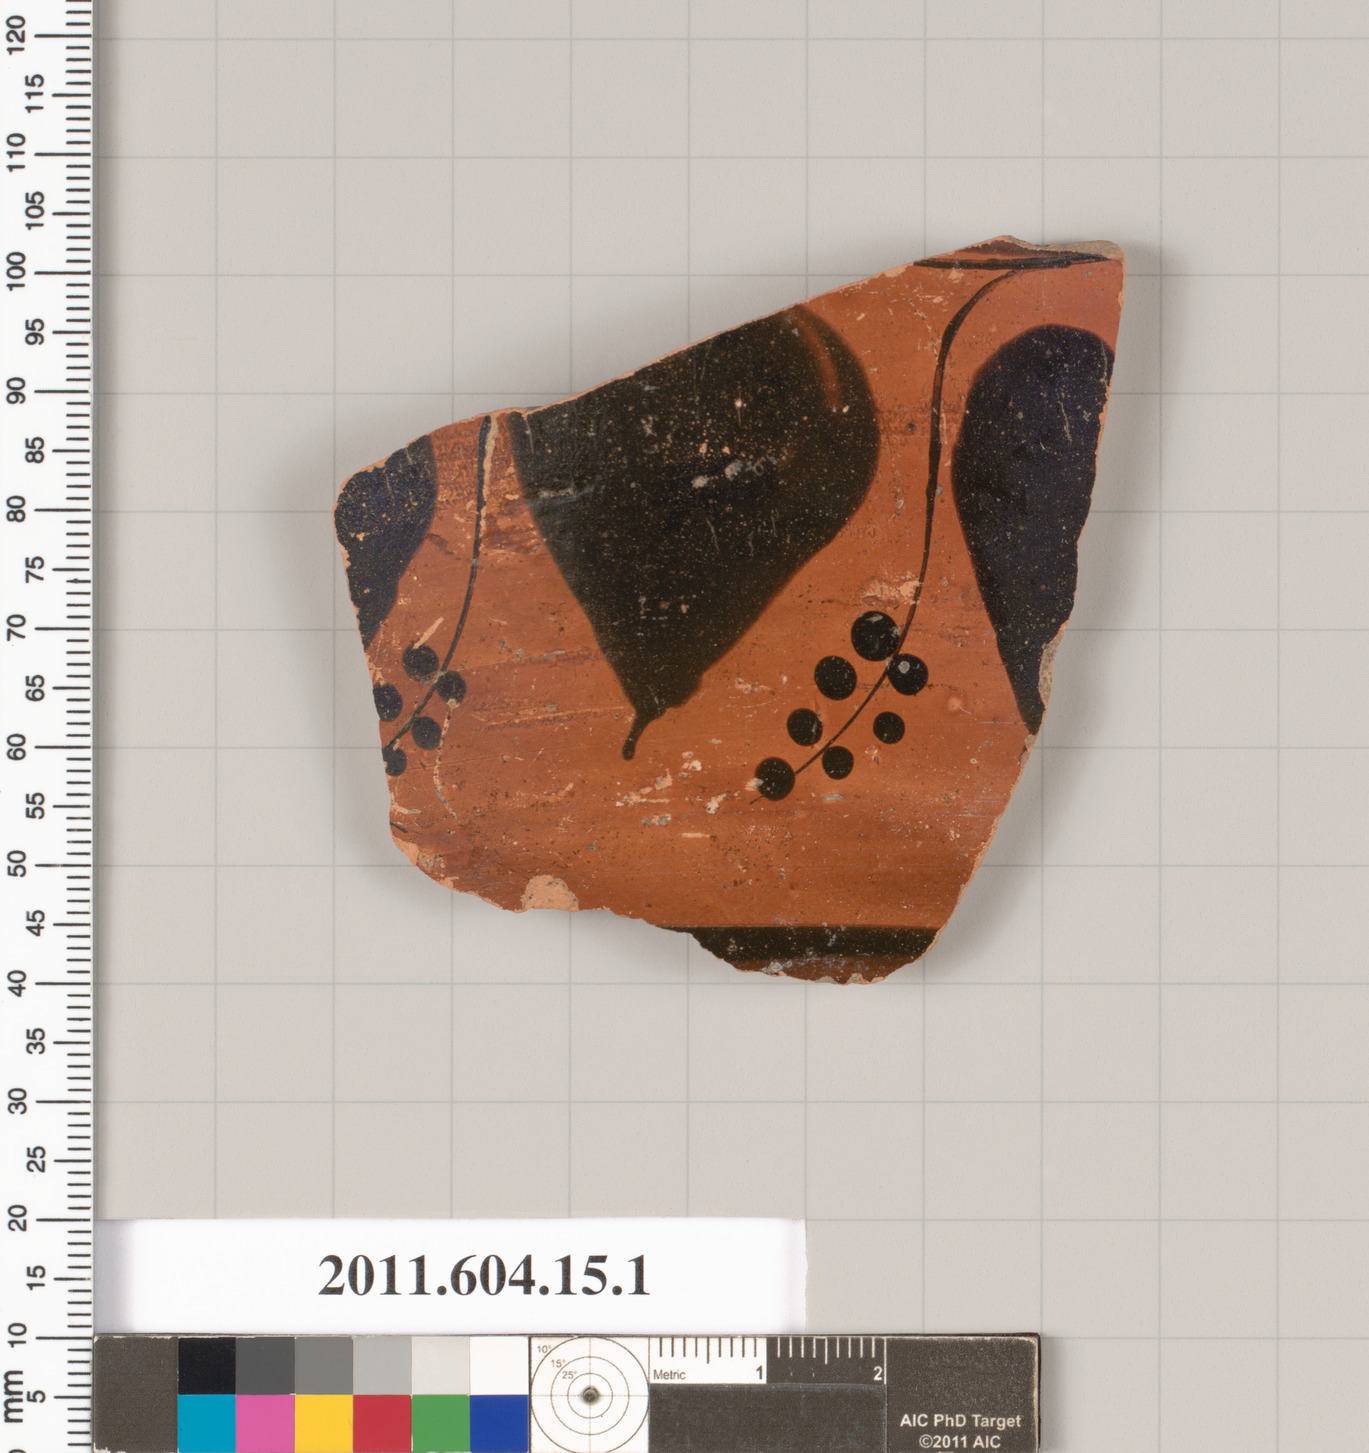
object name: hydria fragment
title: Terracotta fragment of a hydria (water jar)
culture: greek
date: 525-510 BCE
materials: terracotta